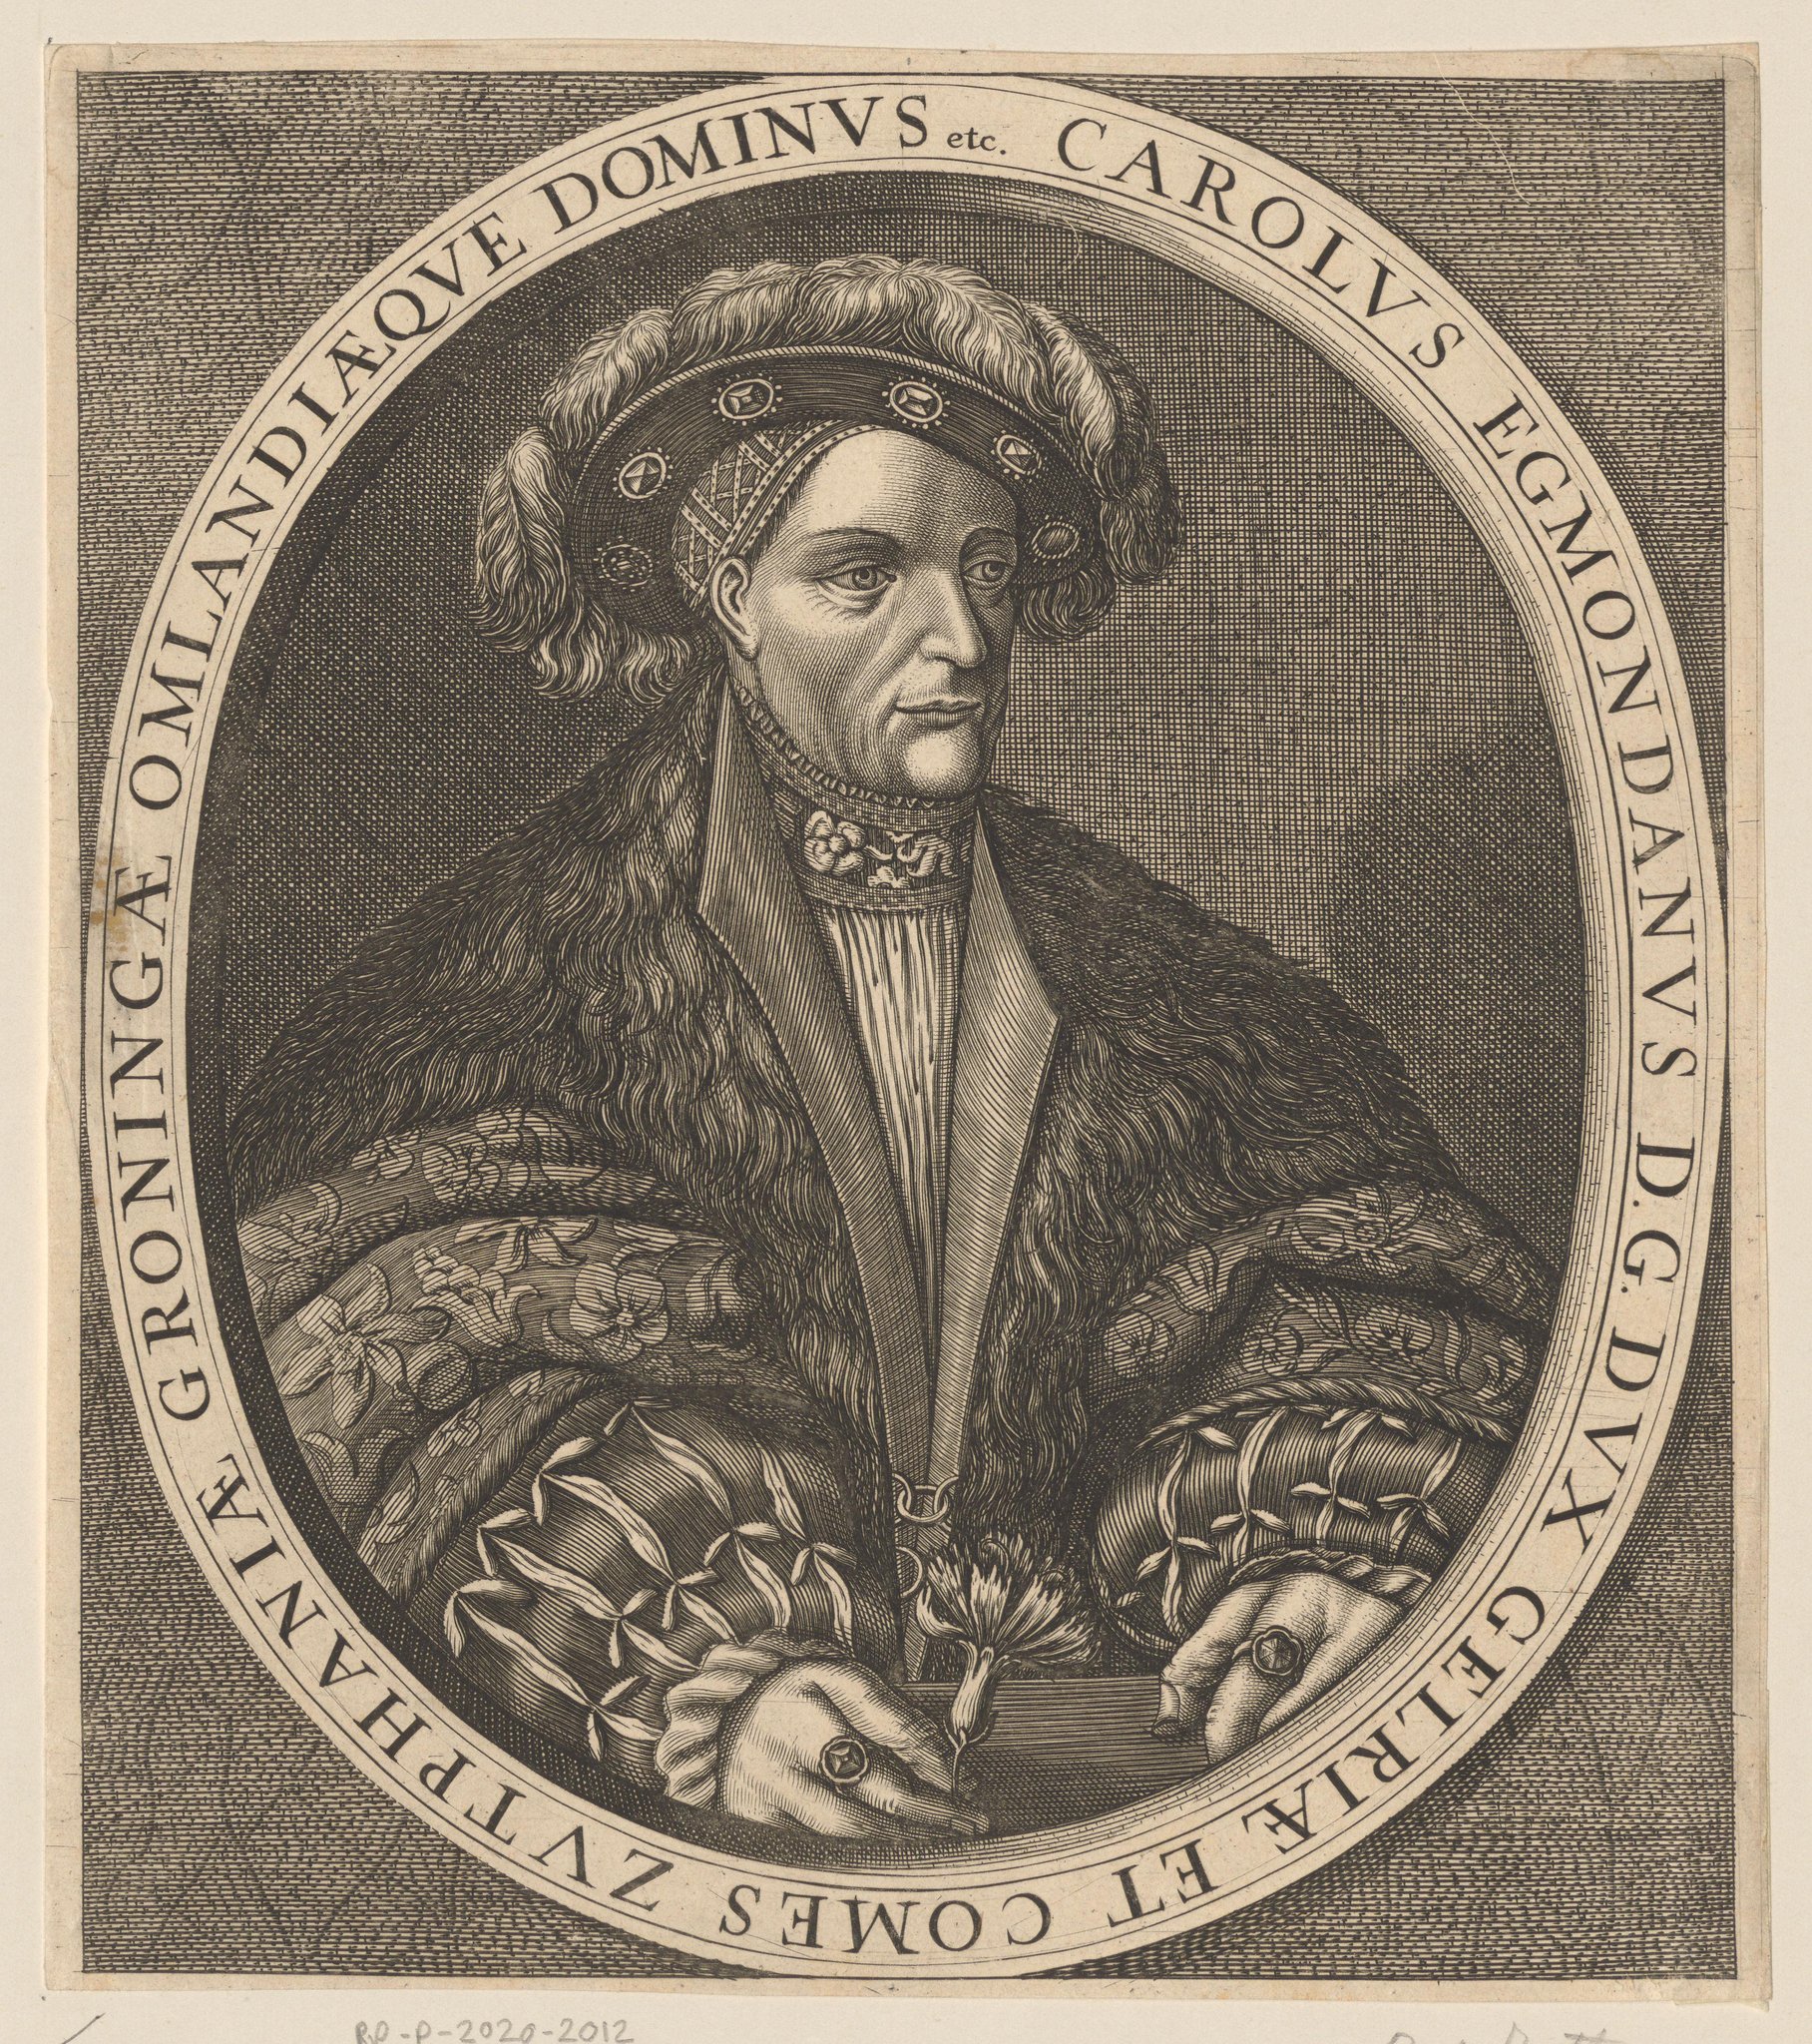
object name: print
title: Portret van Karel van Egmond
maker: paul de zetter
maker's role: print maker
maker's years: 1600-1667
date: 1639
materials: paper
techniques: engraving, etching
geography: northern netherlands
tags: grave, arnhem, earl, karel van egmond, flowers, historical persons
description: Prent waarschijnlijk uit: Pontanus, Johannes Isacius. Historiæ Gelricæ libri XIV. Harderwijk: Nicolaes van Wieringen, Amsterdam: Johannes Janssonius, 1639.